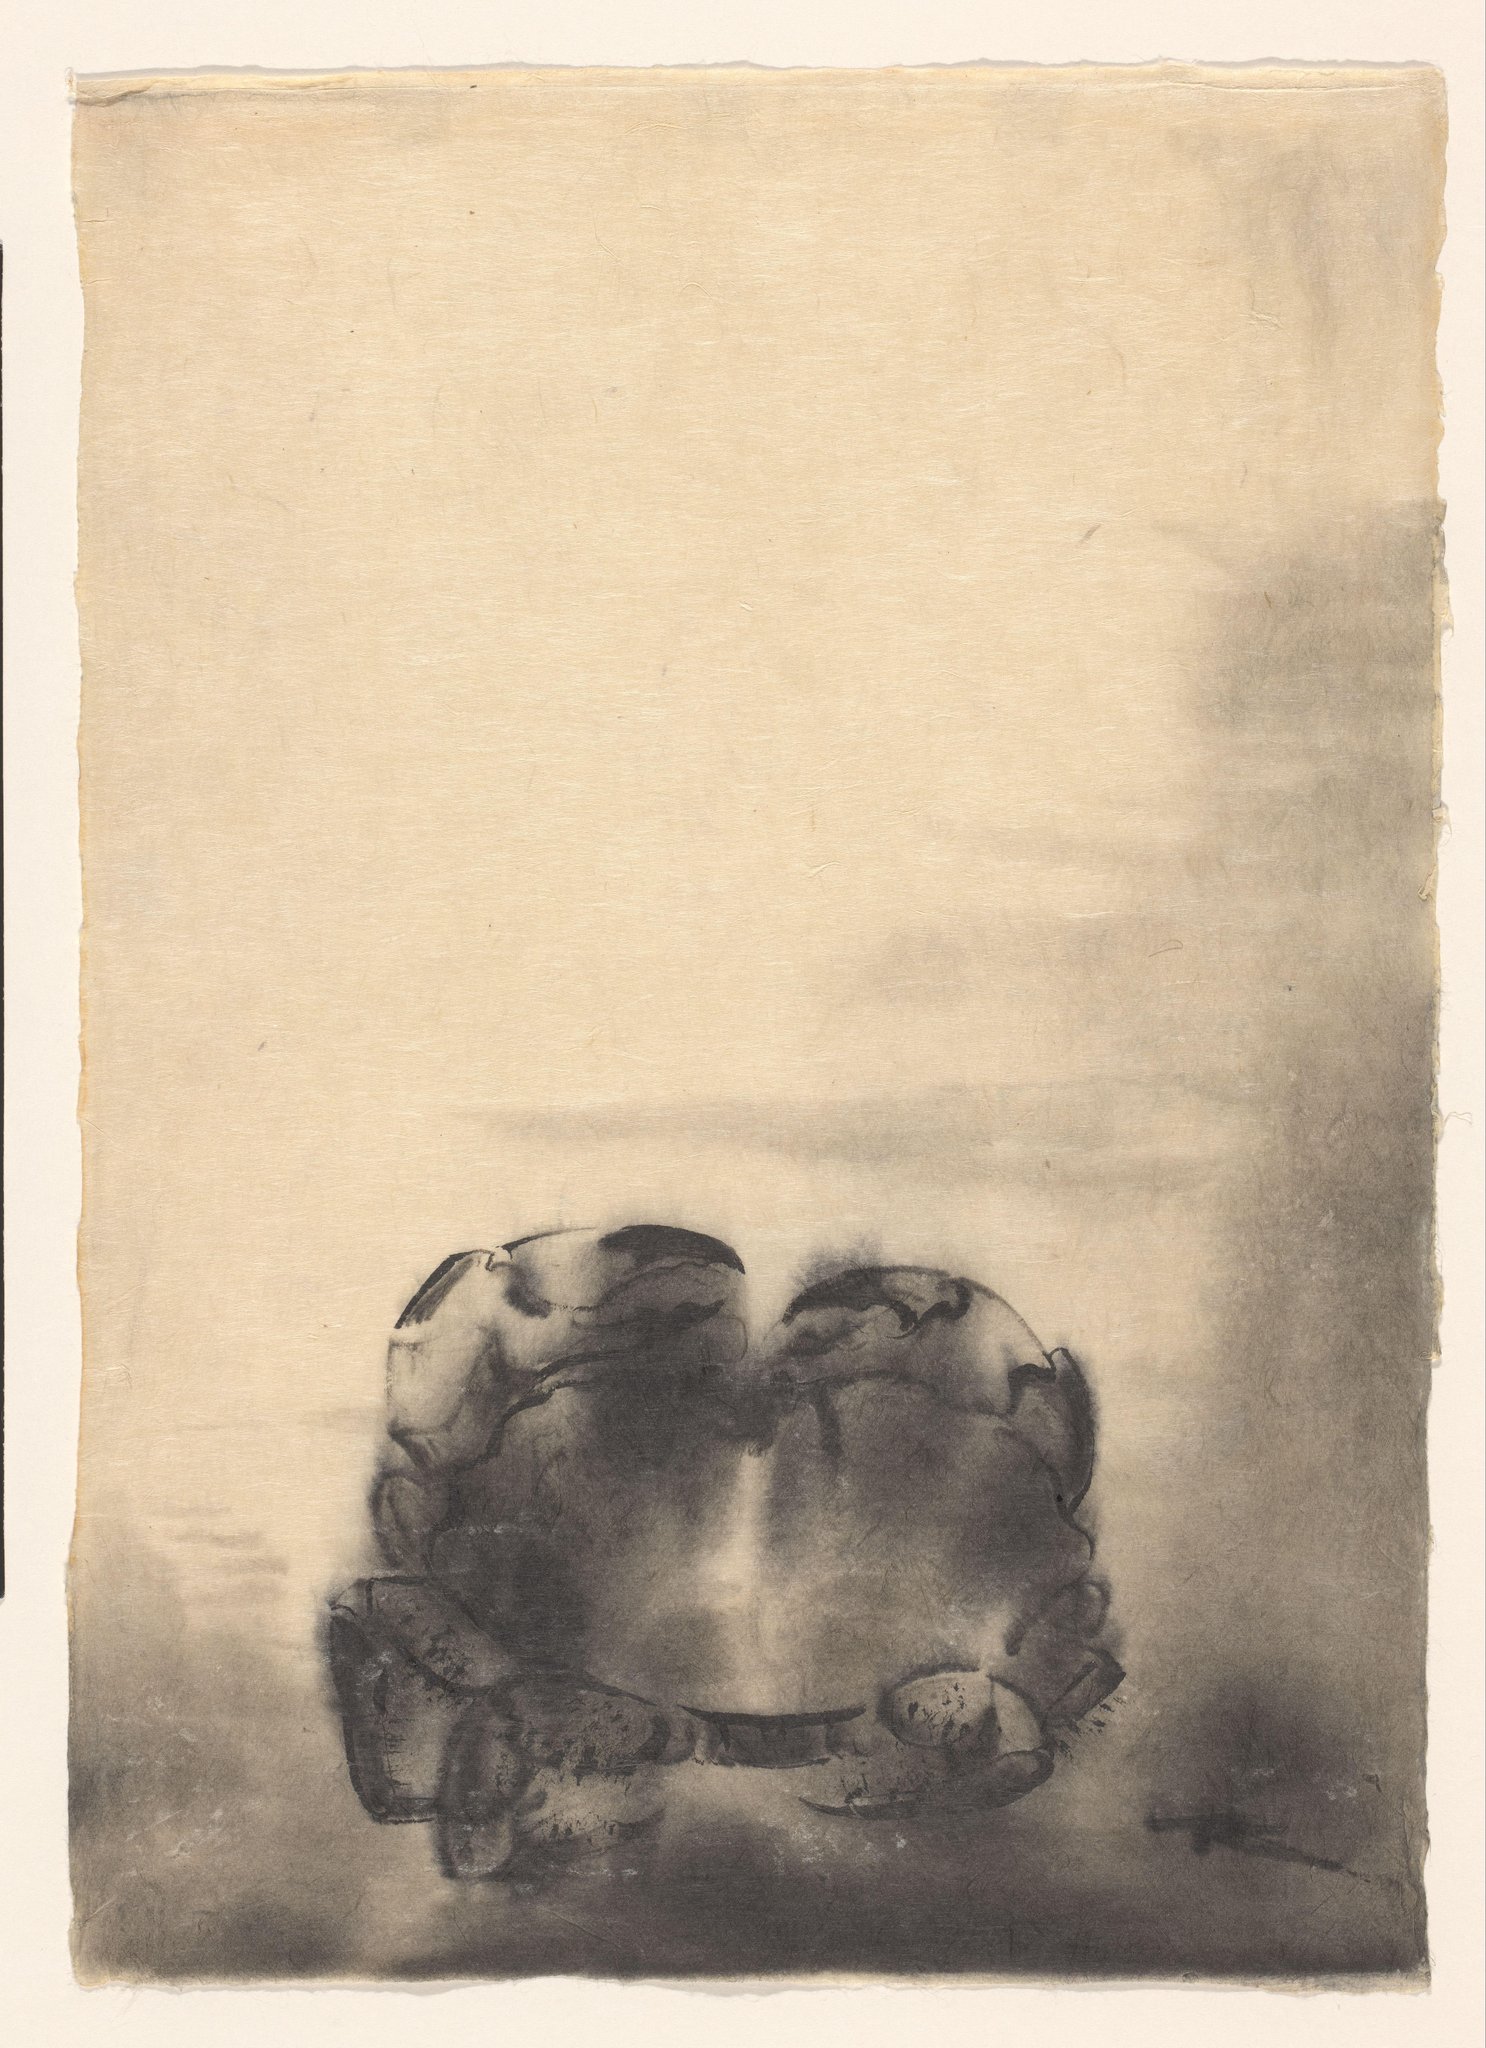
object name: drawing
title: Krab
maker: johannes frederik engelbert ten klooster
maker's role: draughtsman, print maker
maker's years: 1873-1940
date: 1883-1931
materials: ink, paper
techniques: brush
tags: crustaceans: crab